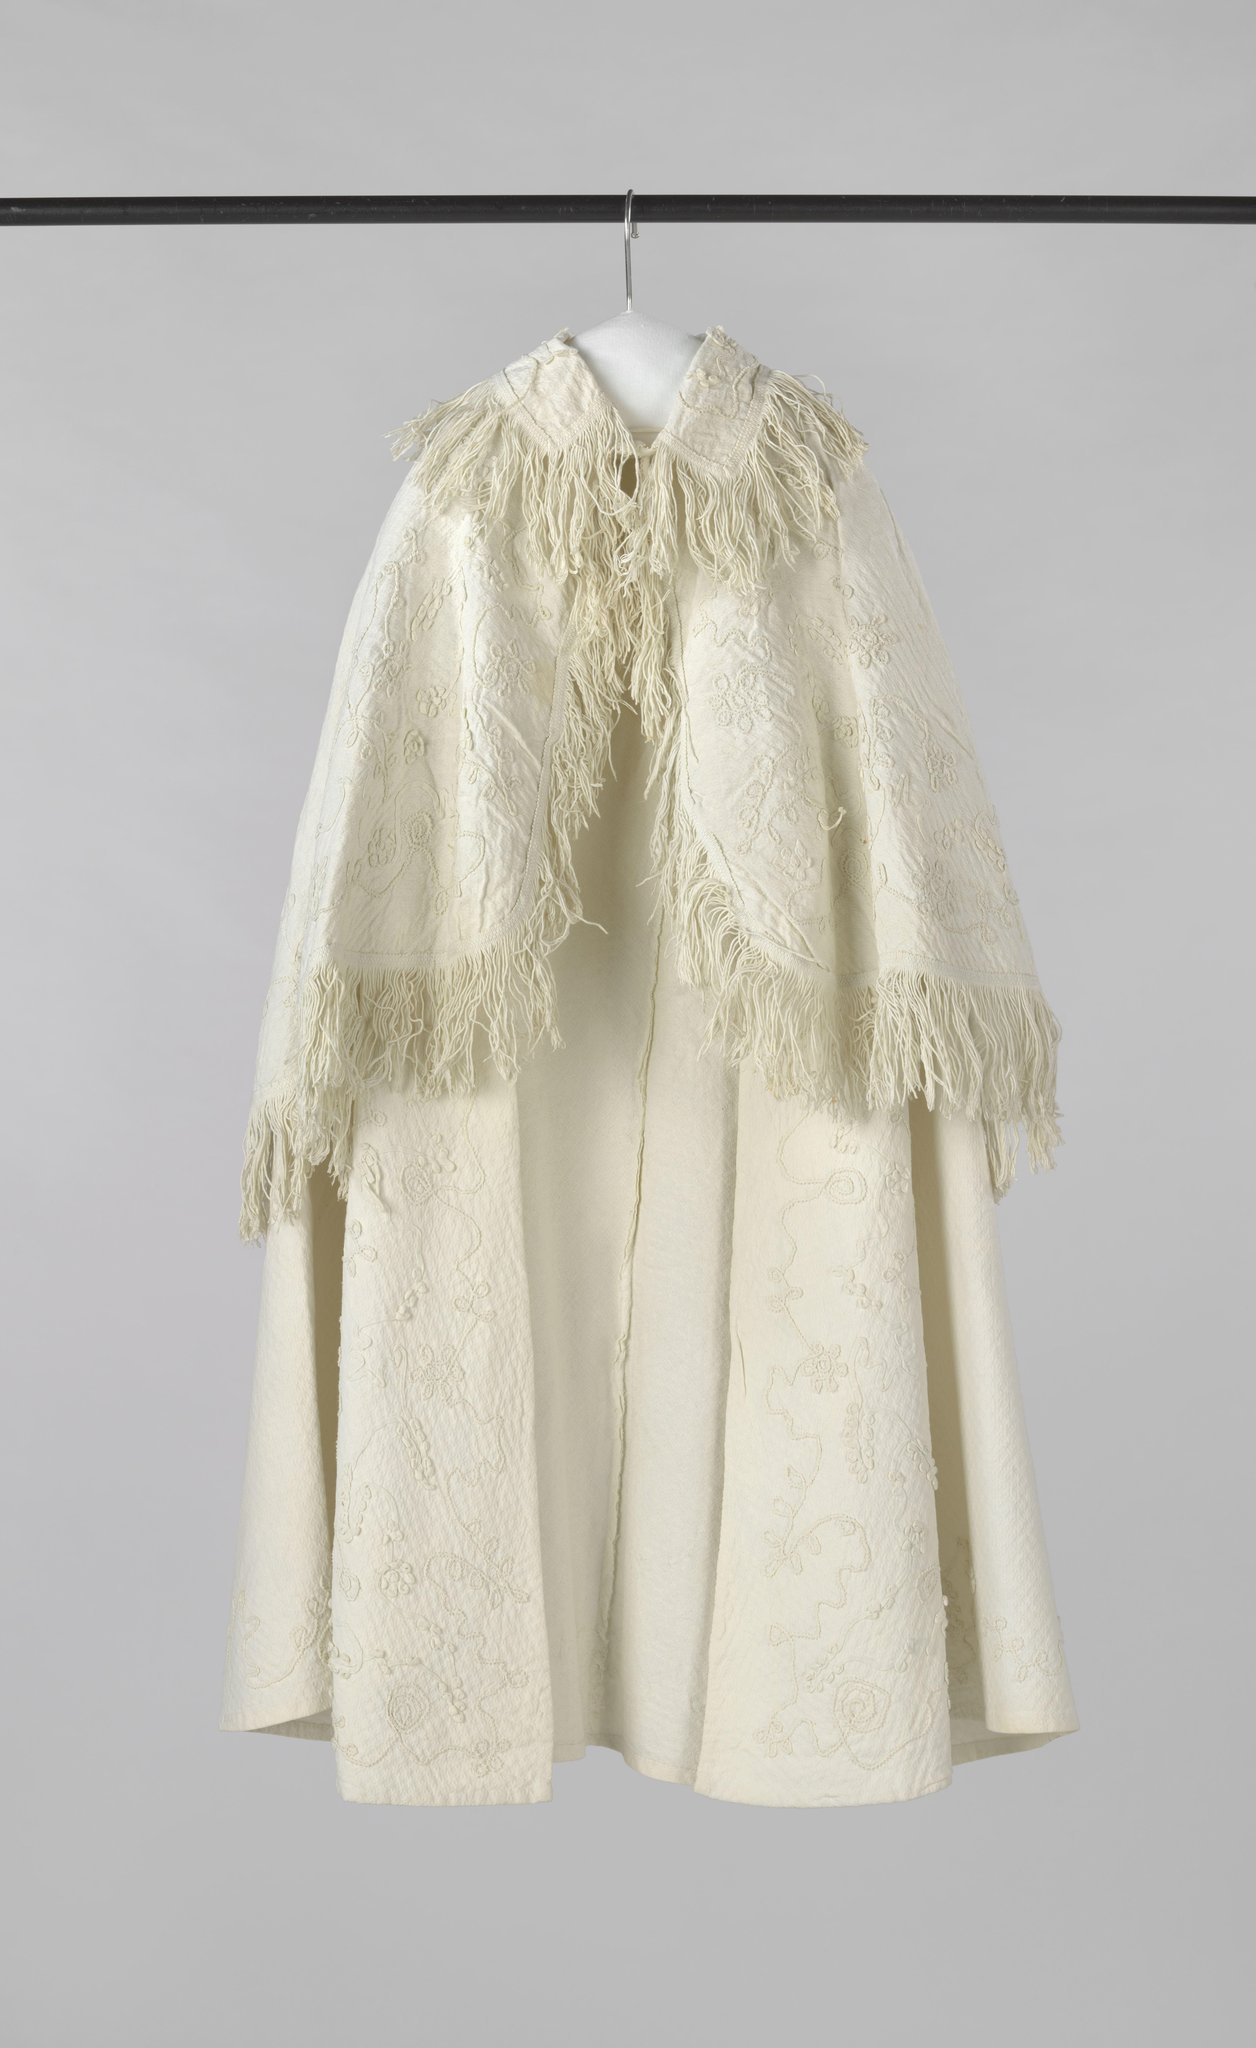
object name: outerwear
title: Pelerine met liggende kraag met franjes van witte piqué, versierd met soutache en franjes.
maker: Anonymous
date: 1880-1890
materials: textile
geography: amsterdam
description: Pelerine, Baby pelisse van piqué met soutache.